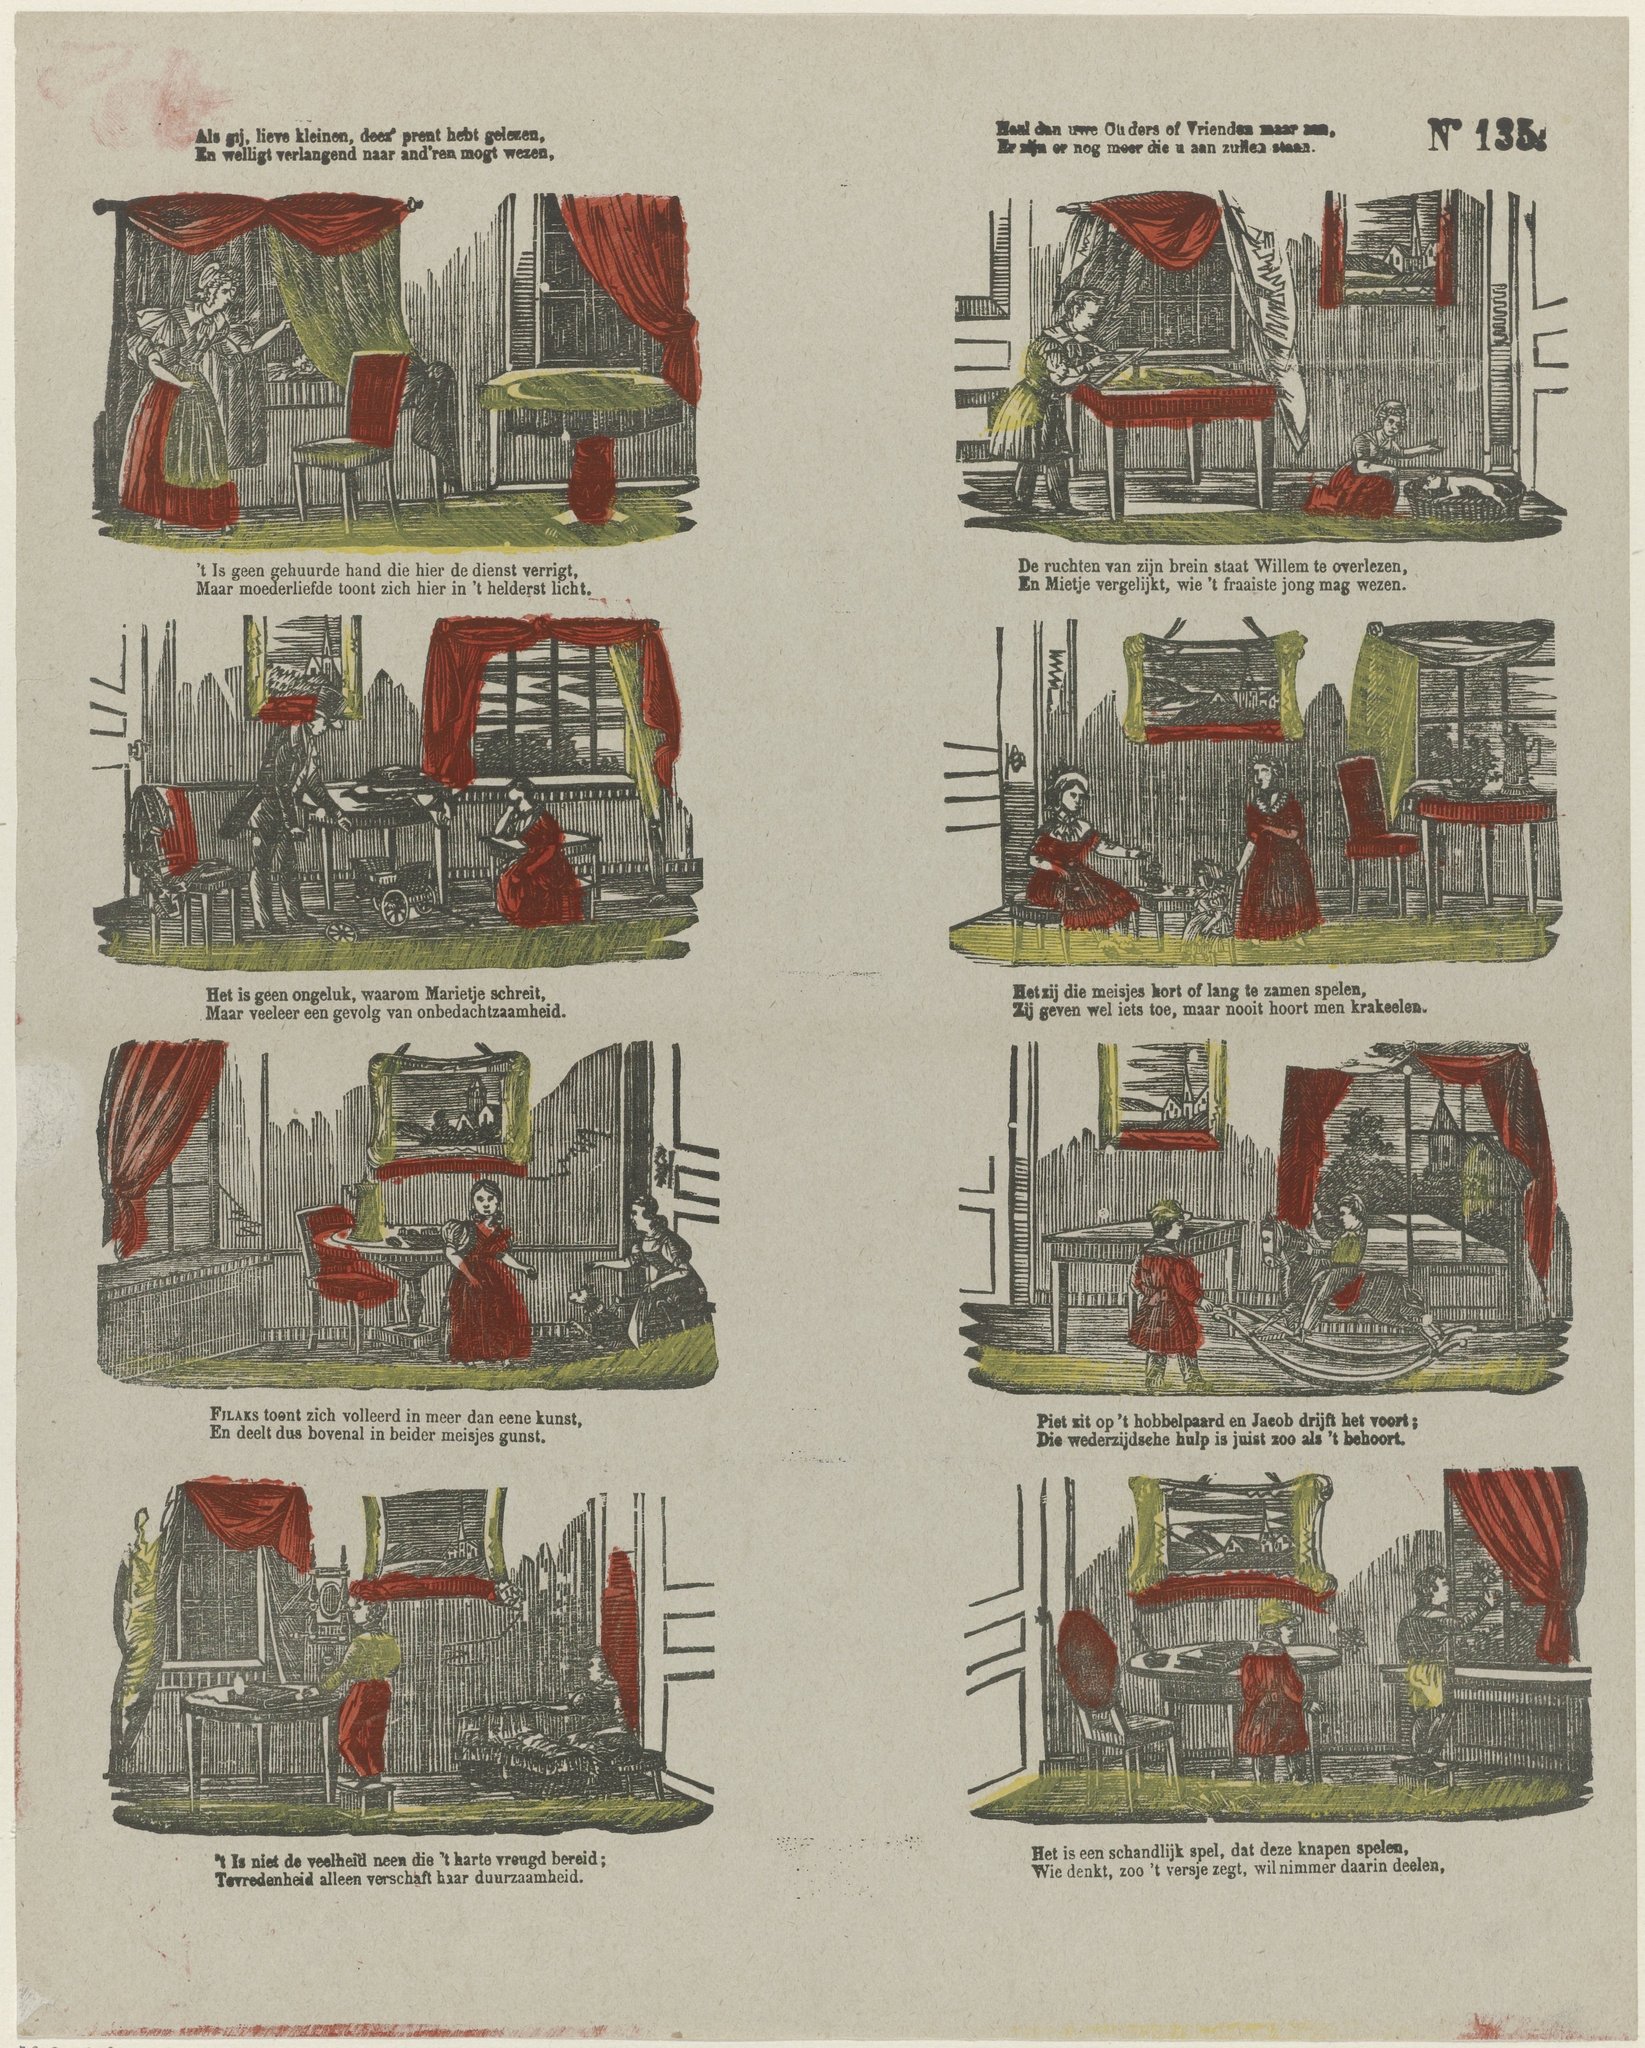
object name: popular print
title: Als gij, lieve kleinen, deez' prent hebt gelezen, / En welligt verlangend naar and'ren mogt wezen, / Haal dan uwe ouders of vriendenmaar aan, / Er zijn er nog meer die u aan zullen staan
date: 1827-1894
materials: paper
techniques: colour, letterpress printing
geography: schaarbeek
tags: education, science and learning, children's games and plays, child playing with animals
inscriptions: collector's mark: Lugt 2760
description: Blad met 8 voorstellingen van bezigheden voor kinderen, zoals studeren en spelen. Onder elke afbeelding een tweeregelig vers. Genummerd rechtsboven: No 135.